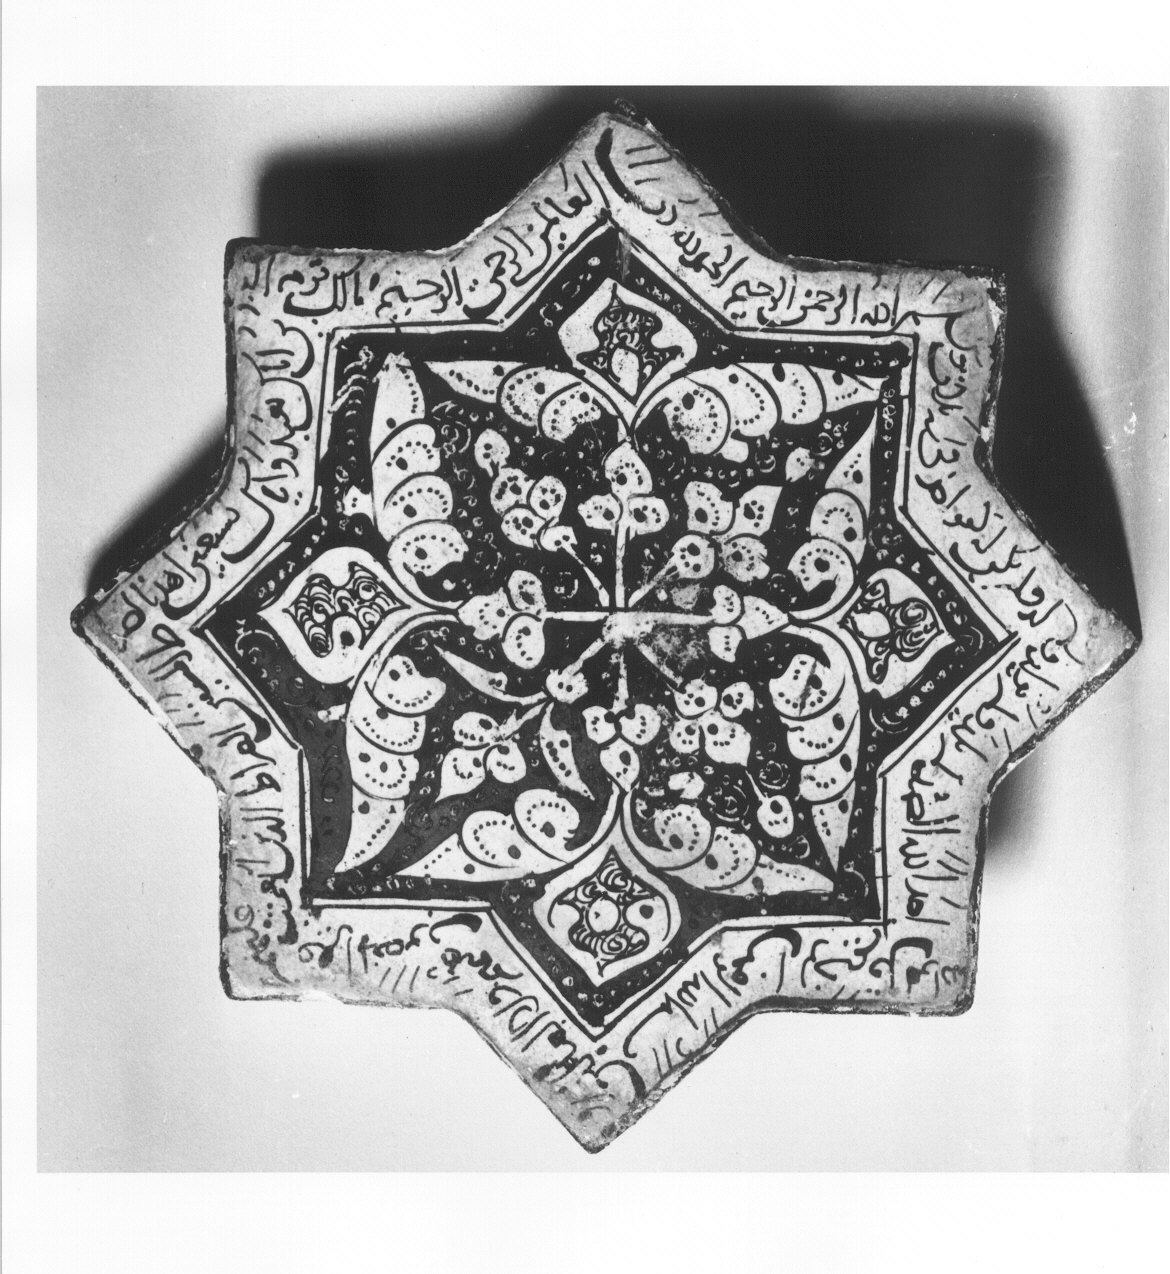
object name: tile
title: Star-Shaped Tile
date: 1264-1265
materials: cobalt, glaze, stonepaste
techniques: luster painting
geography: iran